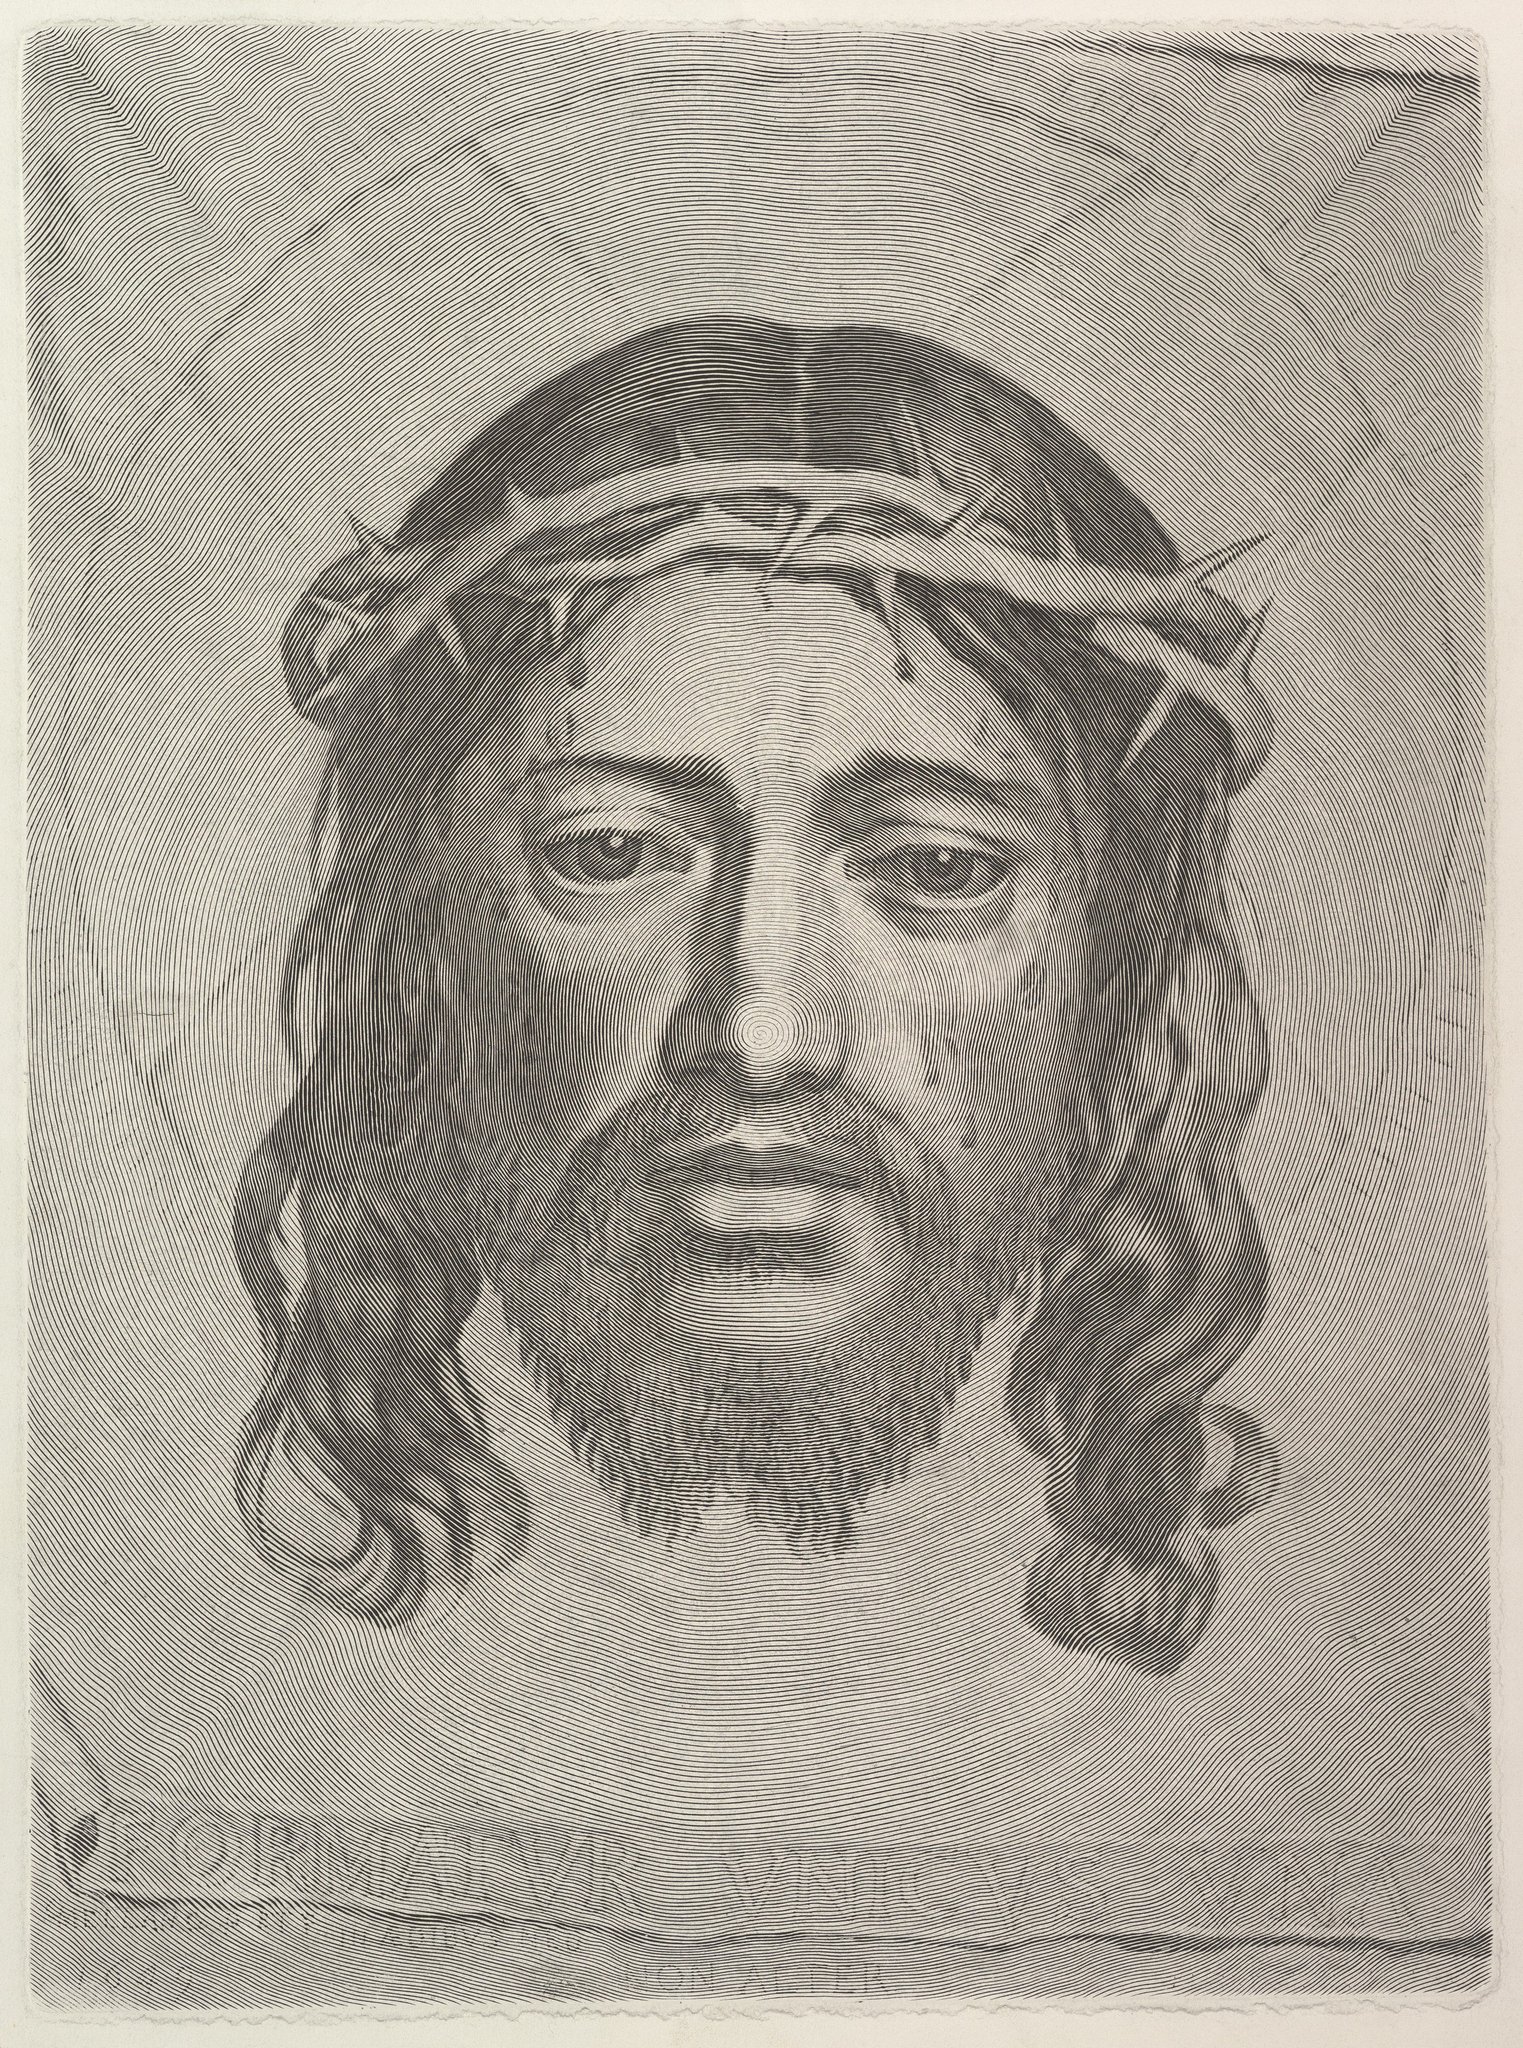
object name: print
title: Face of Christ on St. Veronica's Cloth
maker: claude mellan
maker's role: artist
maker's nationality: french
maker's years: 1598-1688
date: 1649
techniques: engraving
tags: christ